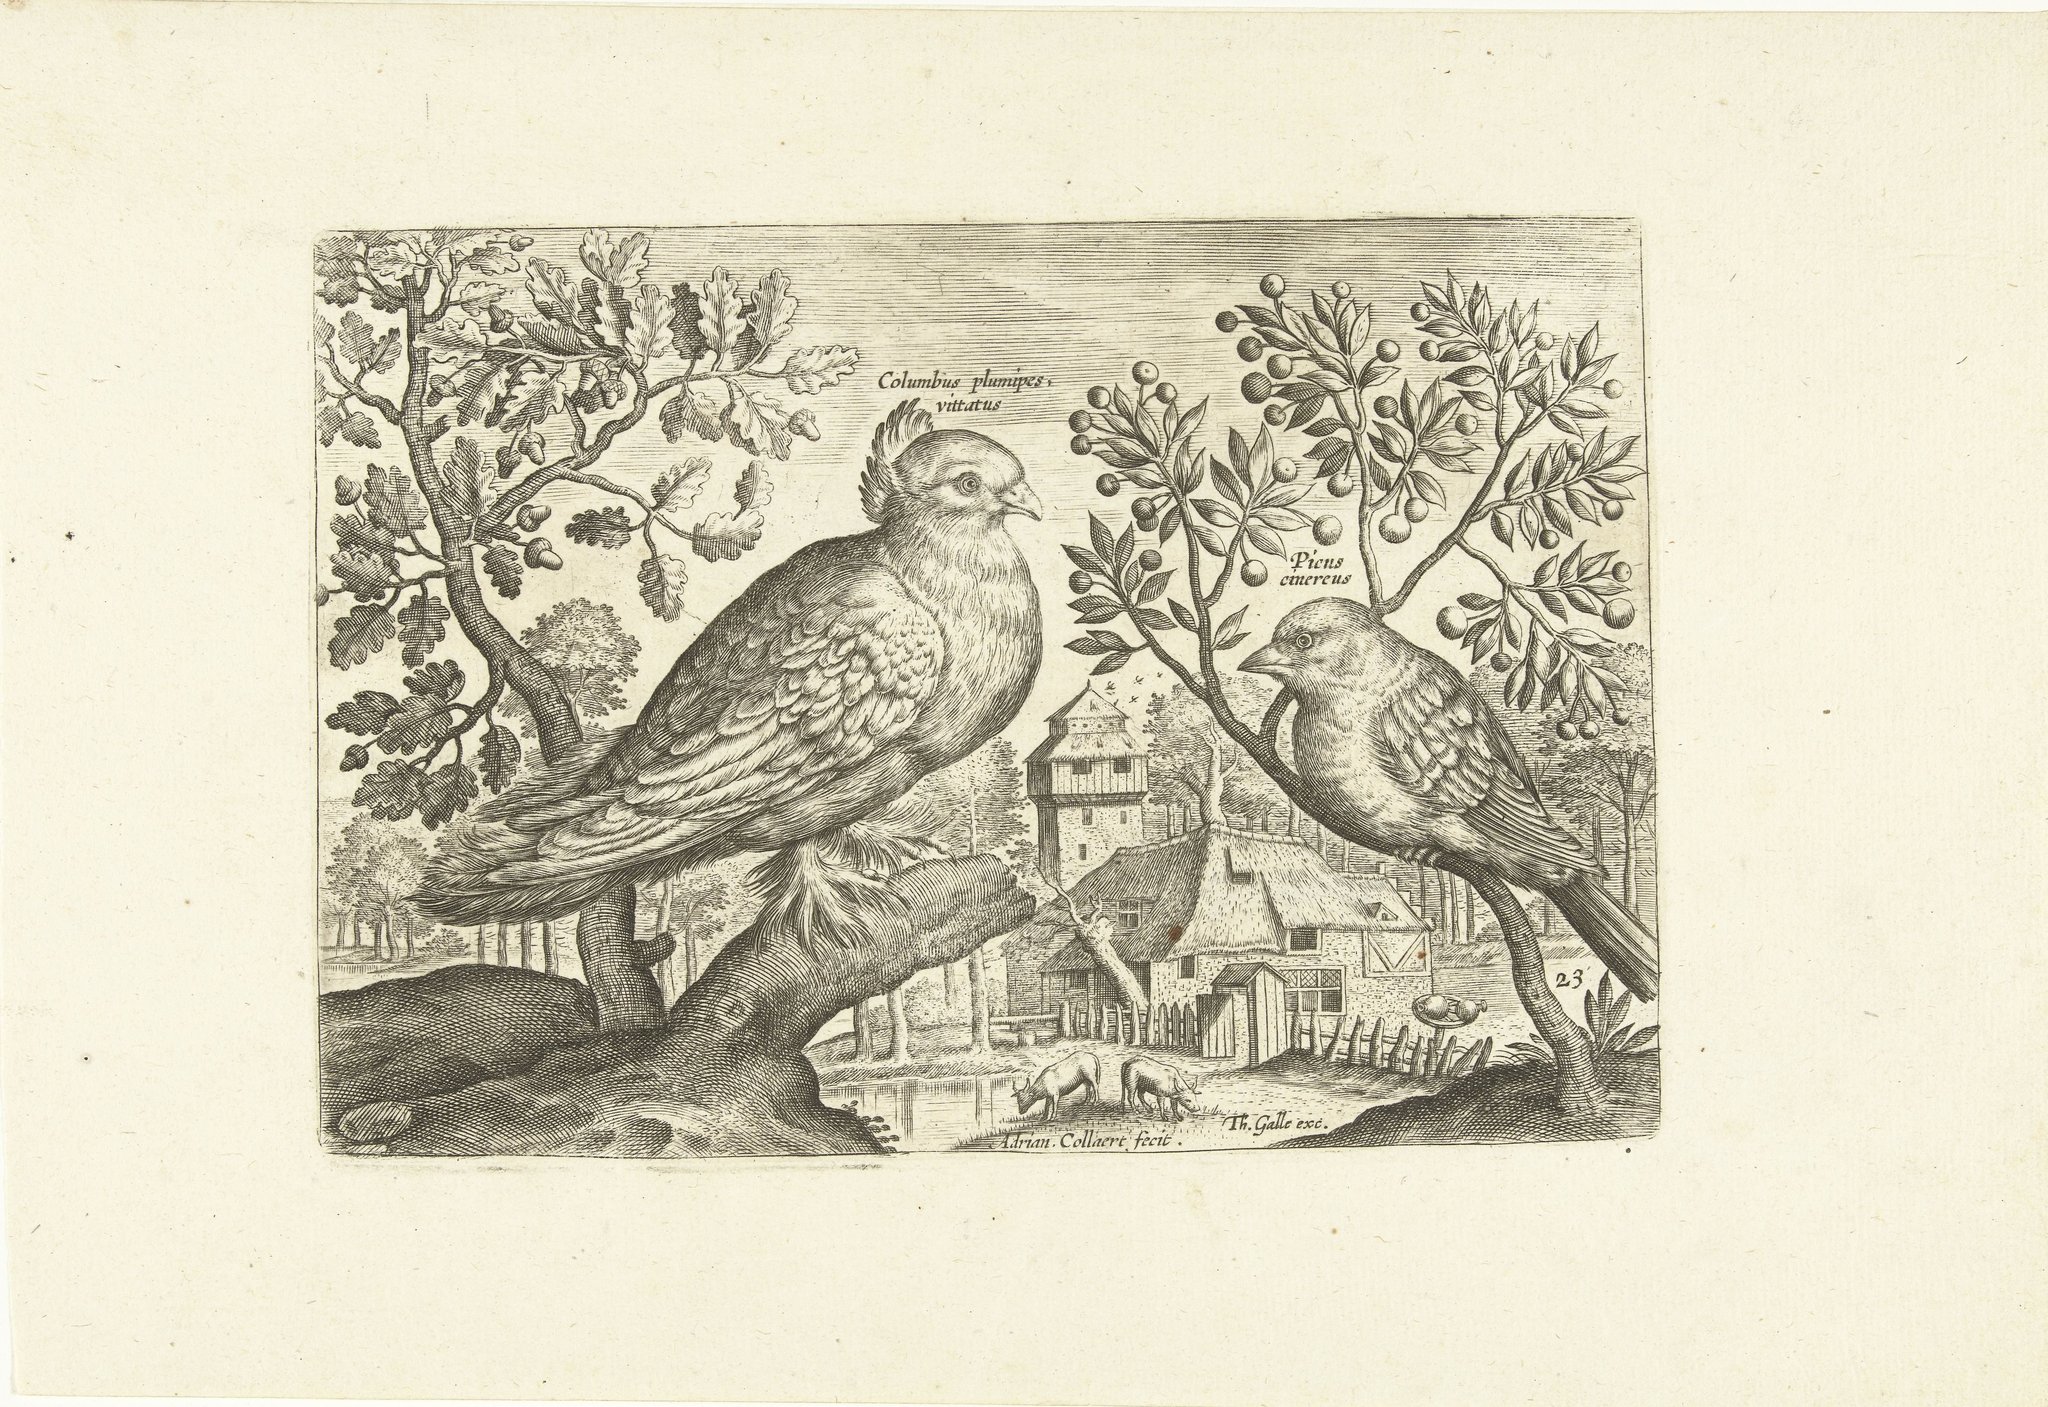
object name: print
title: Vogels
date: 1598-1618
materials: paper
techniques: engraving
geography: antwerp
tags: song-birds: finch, farm or solitary house in landscape, doves, pigeons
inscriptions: collector's mark: Lugt 2228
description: Een duif en een vink in een landschap met een hoeve. De prent maakt deel uit van een serie met vogels als onderwerp.